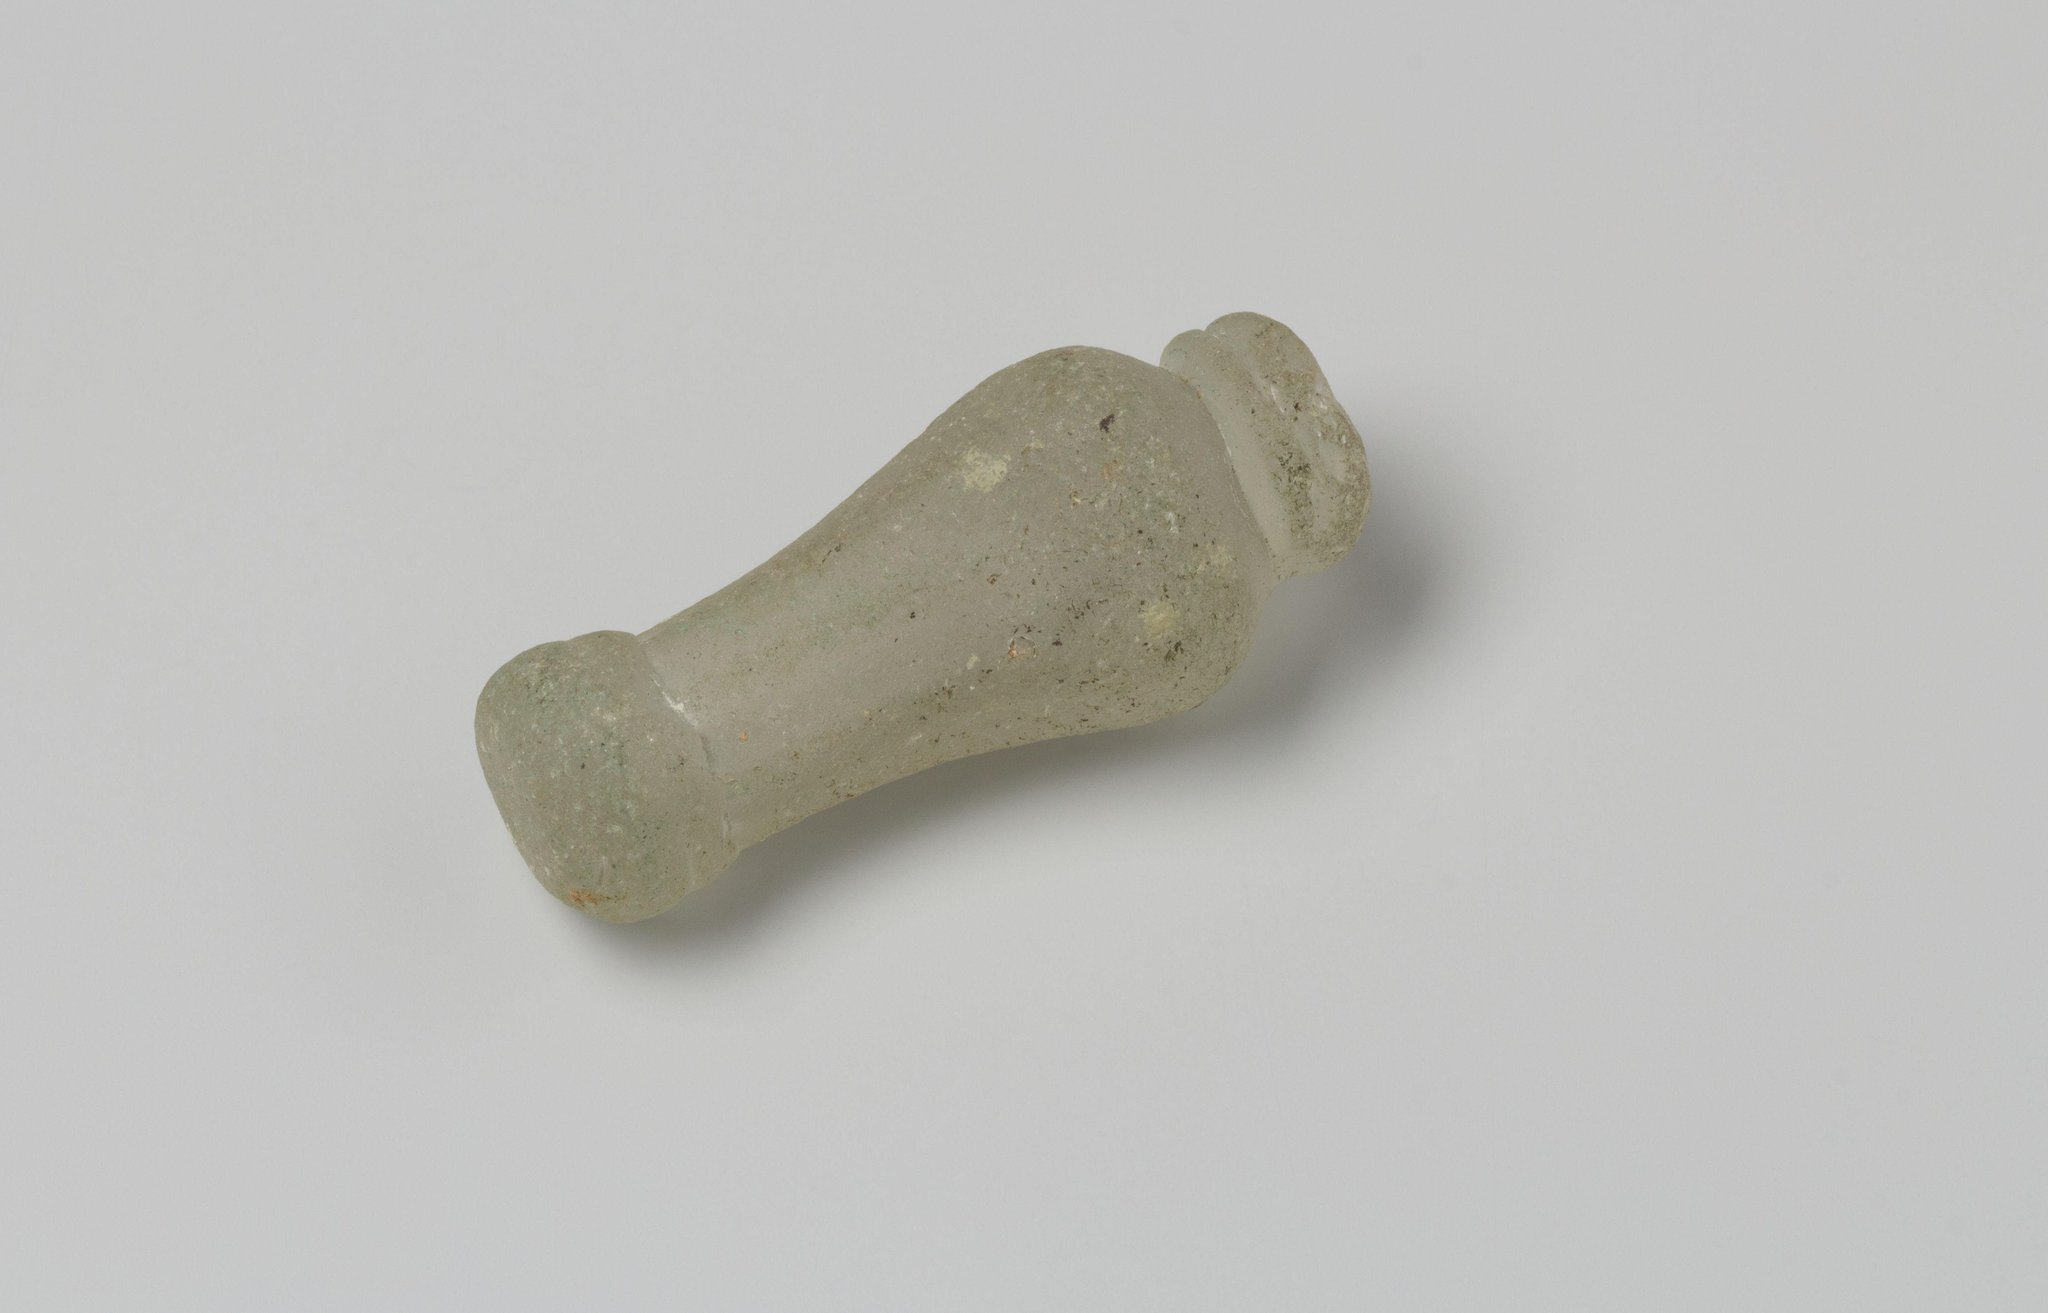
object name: drinking glass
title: Gefacetteerde steel van een fluitglas uit het wrak van de Oost-Indiëvaarder Hollandia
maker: Anonymous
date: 1700-1743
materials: glass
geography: netherlands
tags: verenigde oostindische compagnie, hollandia (schip), annet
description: Glass, stem glass, steel, faceted; fragment, solid, inverted baluster, octagonal faceted, with flattened knops on both ends, broken, solid.